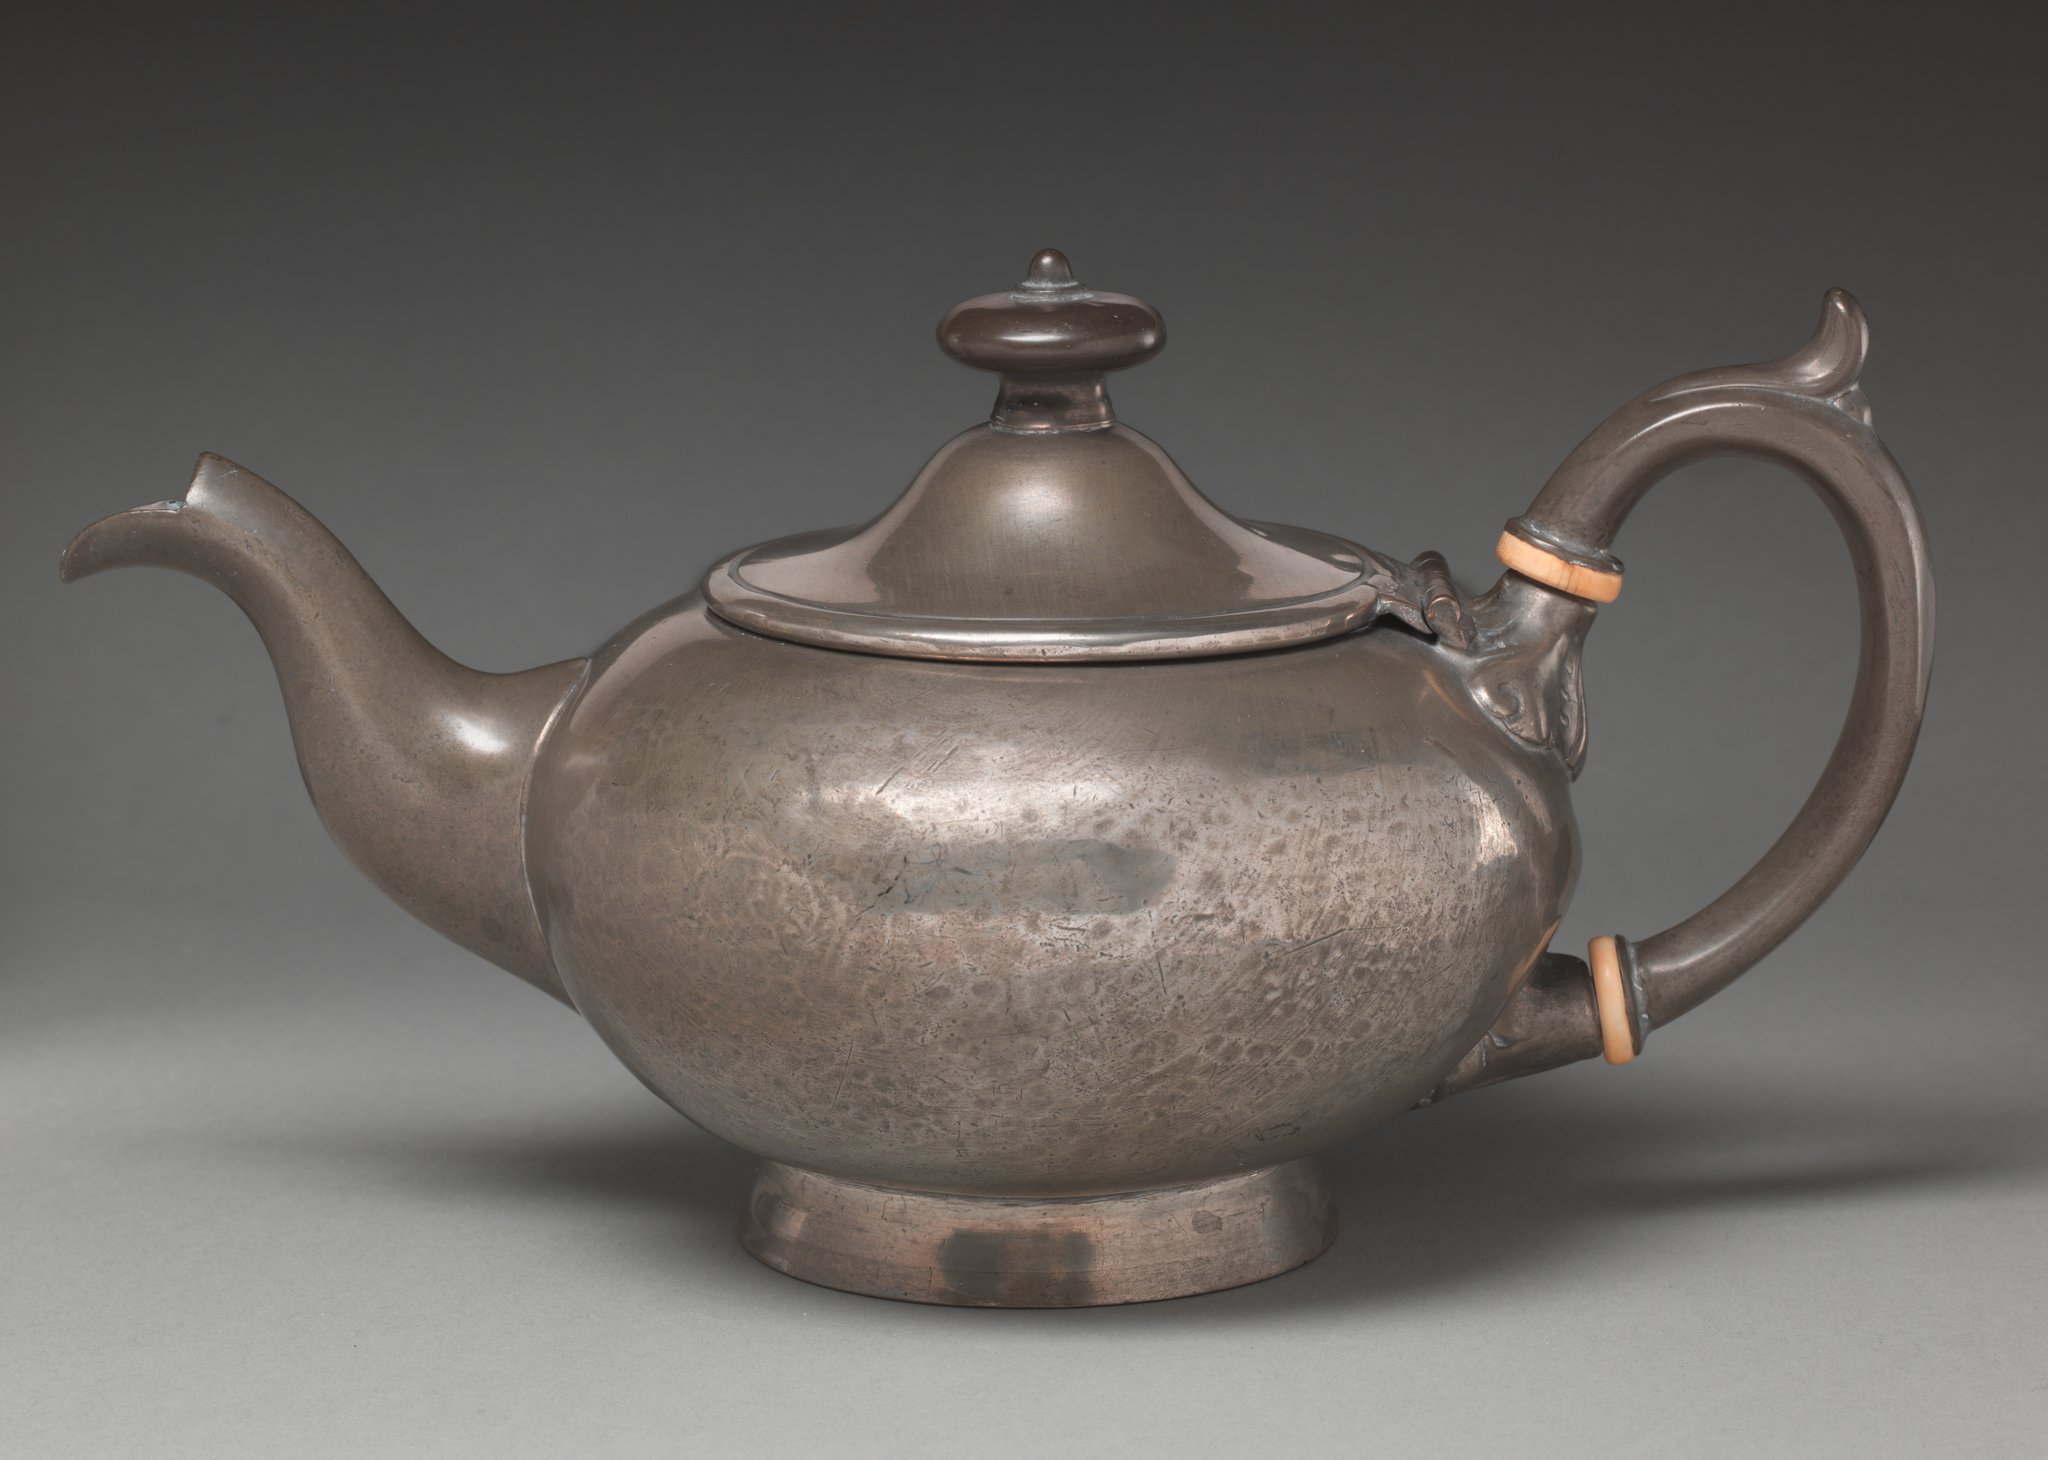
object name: teapot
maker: james dixon & sons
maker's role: maker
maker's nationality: british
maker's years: 1806-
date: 1842-1851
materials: bone, metal